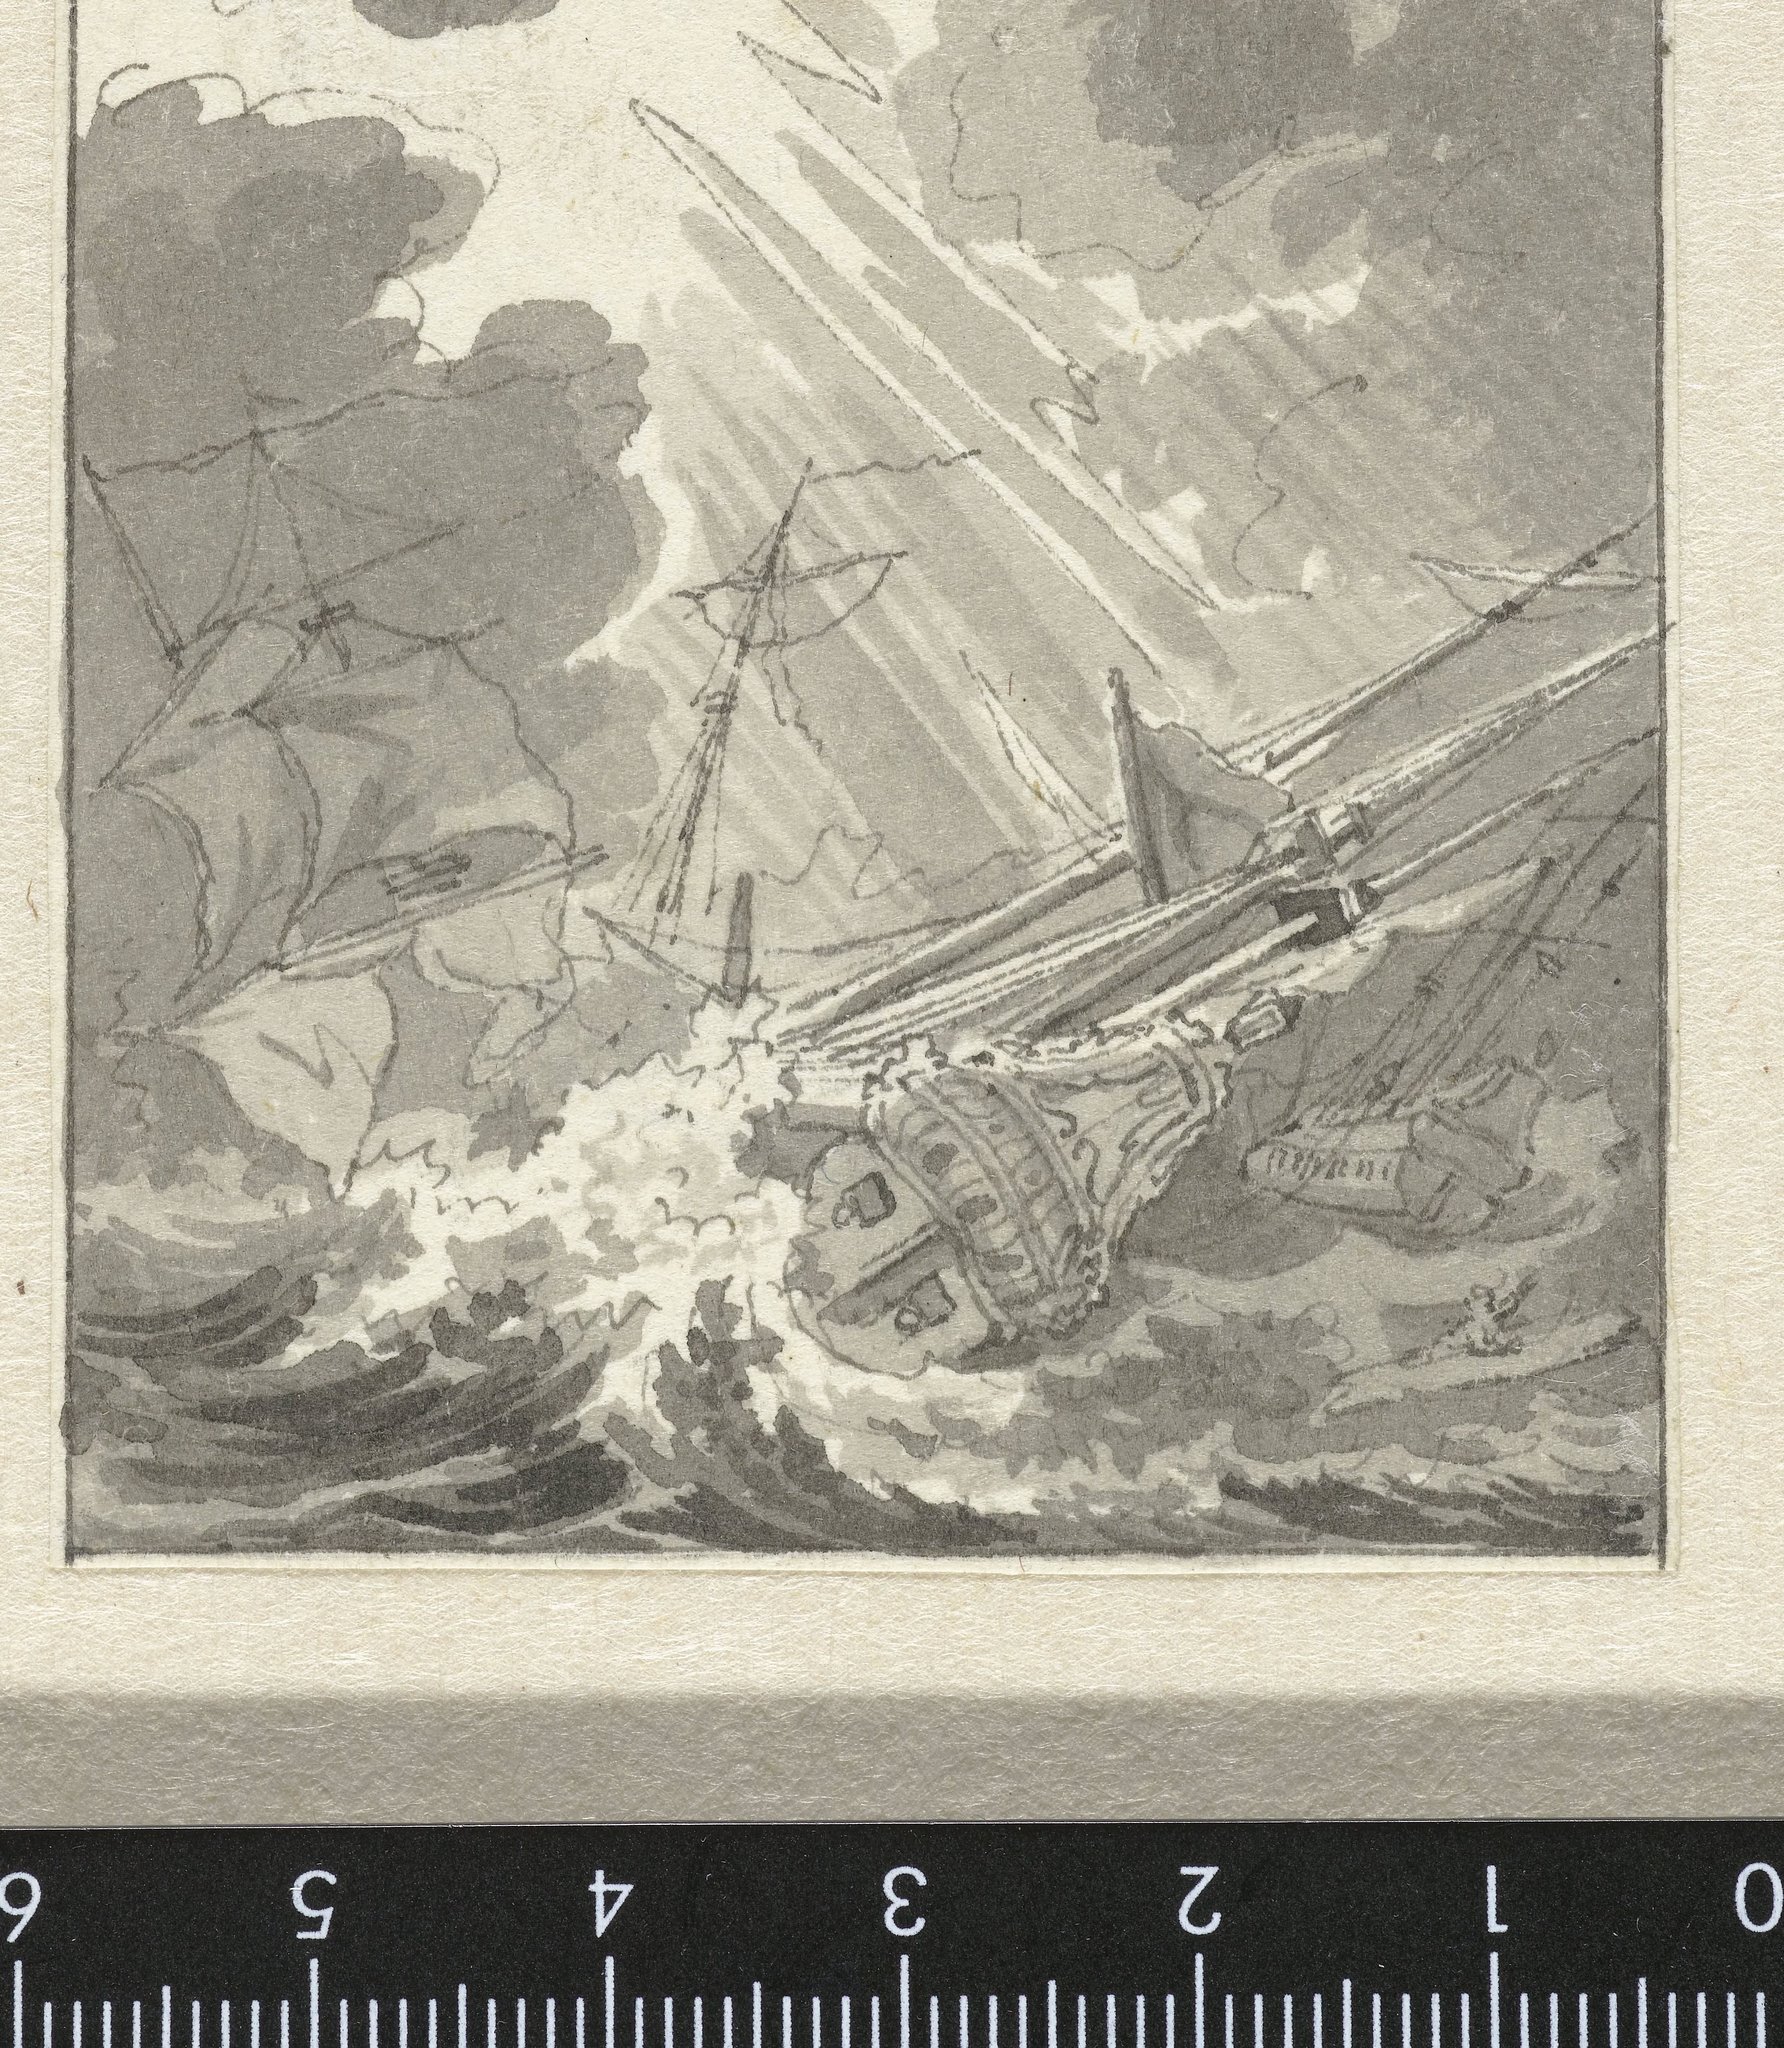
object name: drawing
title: In 't Jaar 1559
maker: Anonymous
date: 1789-1810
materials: ink, paper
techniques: brush, pen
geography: netherlands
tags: storm at sea